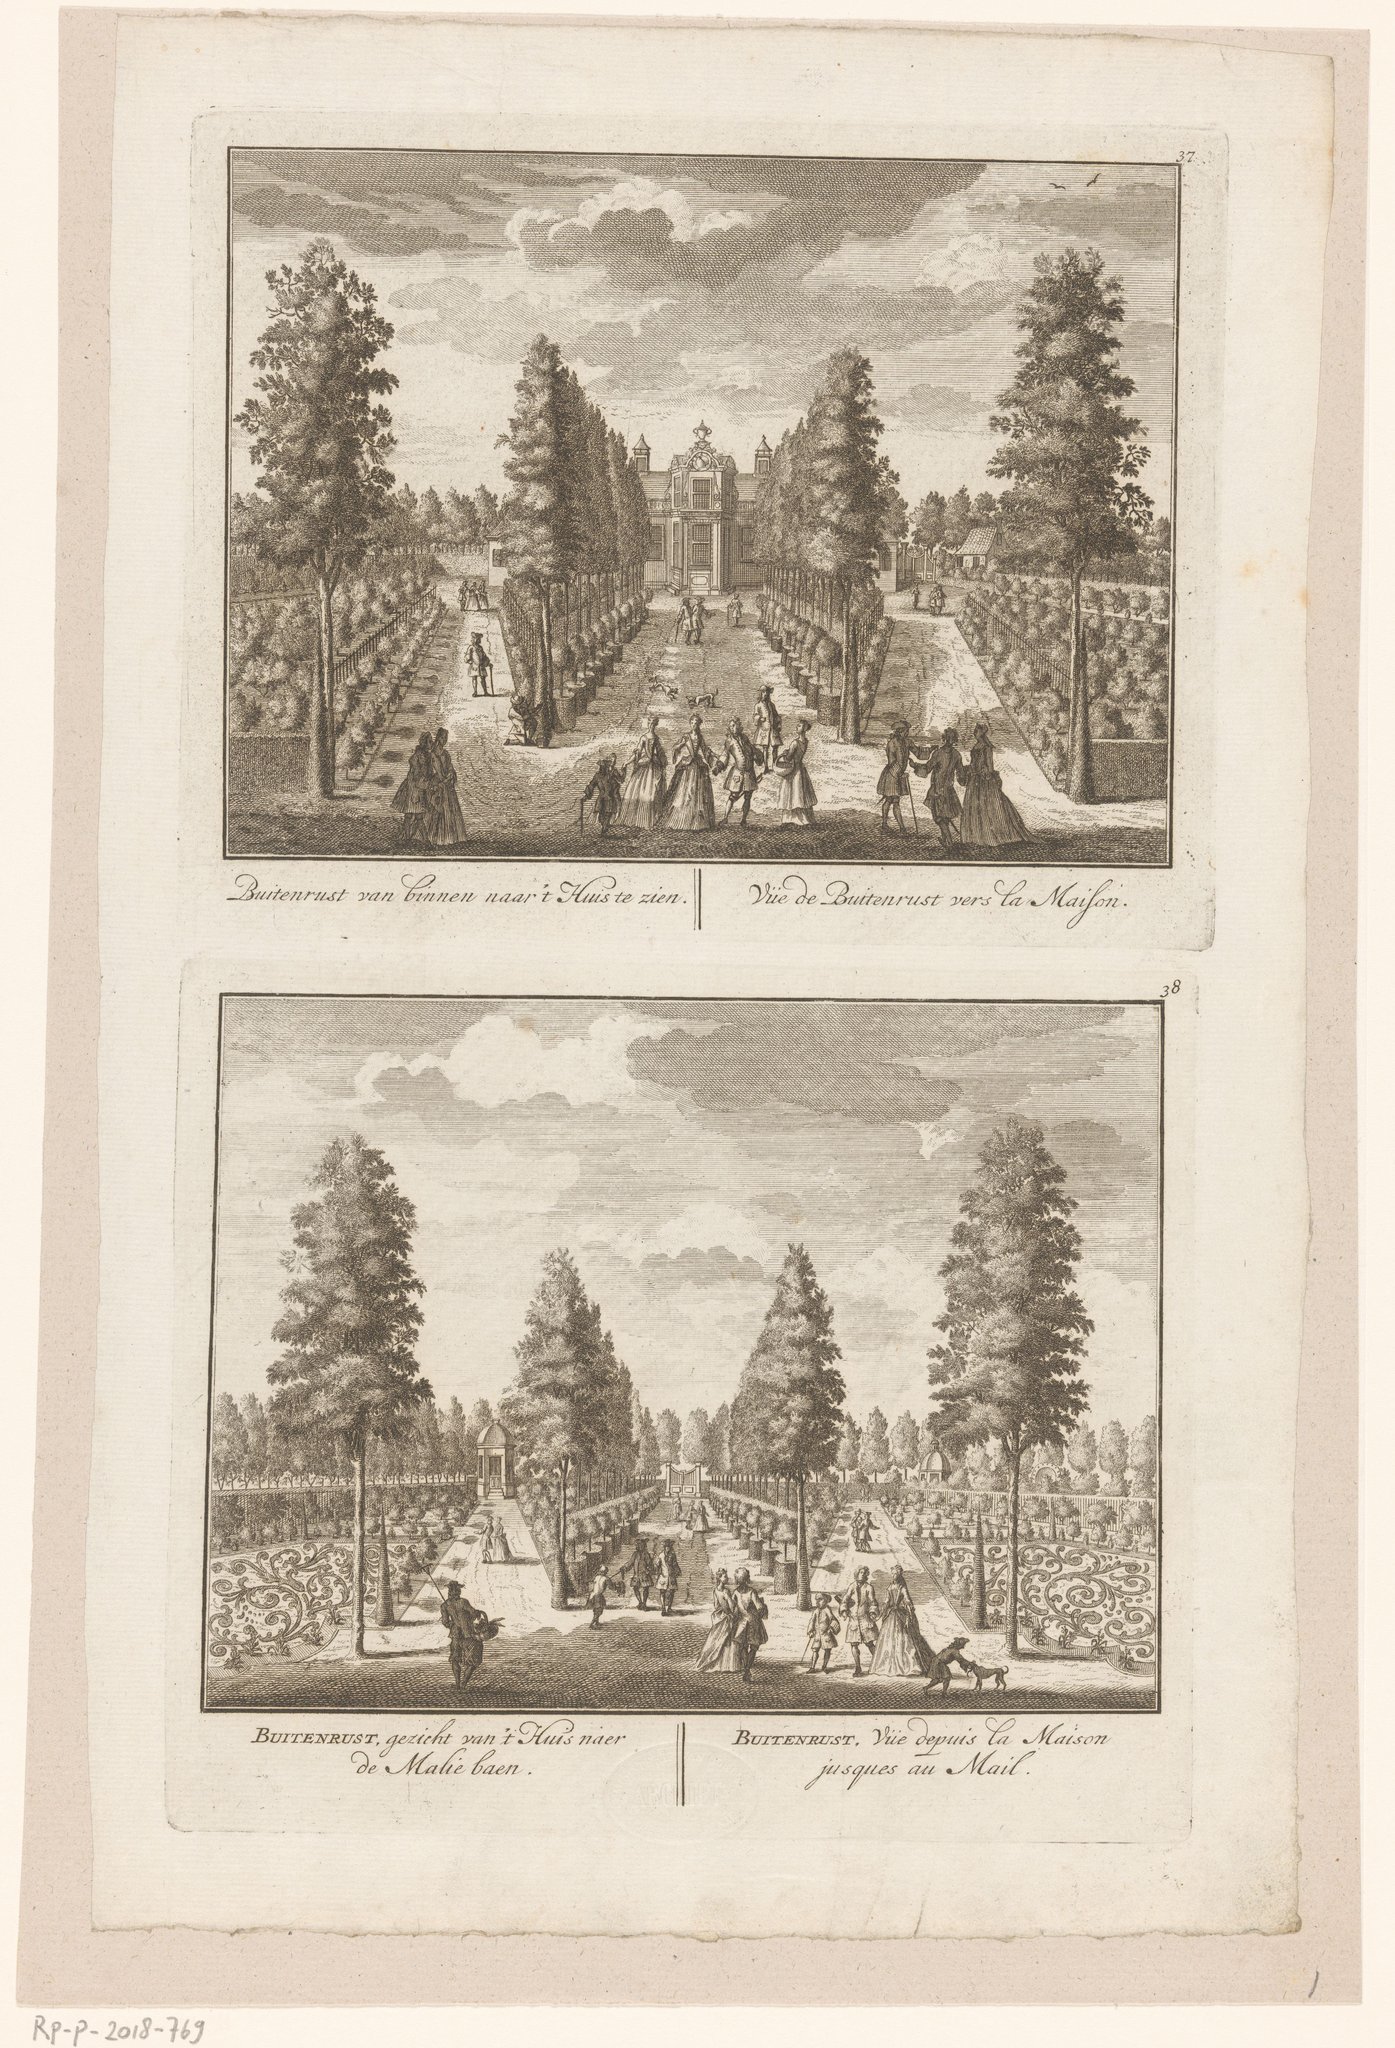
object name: book illustration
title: Gezicht op buitenplaats Buitenrust en gezicht op de tuinen van buitenplaats Buitenrust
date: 1725-1768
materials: paper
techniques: engraving, etching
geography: amsterdam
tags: french or architectonic garden; formal garden, country-house, amsterdam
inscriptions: check stamp: ‘Archief Ministerie van Oorlog Afdeeling Genie’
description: Prent gebruikt in: Niedek, Mattaeus Brouërius. Het verheerlykt Watergraafs- of Diemermeer by de stadt Amsterdam (...). Amsterdam: Andries en Hendrik de Leth, 1725. Of in: Niedek, Mattaeus Brouërius. Het verheerlykt Watergraafs- of Diemermeer by de stadt Amsterdam (...). Amsterdam: Pieter Jan Entrop, 1768.